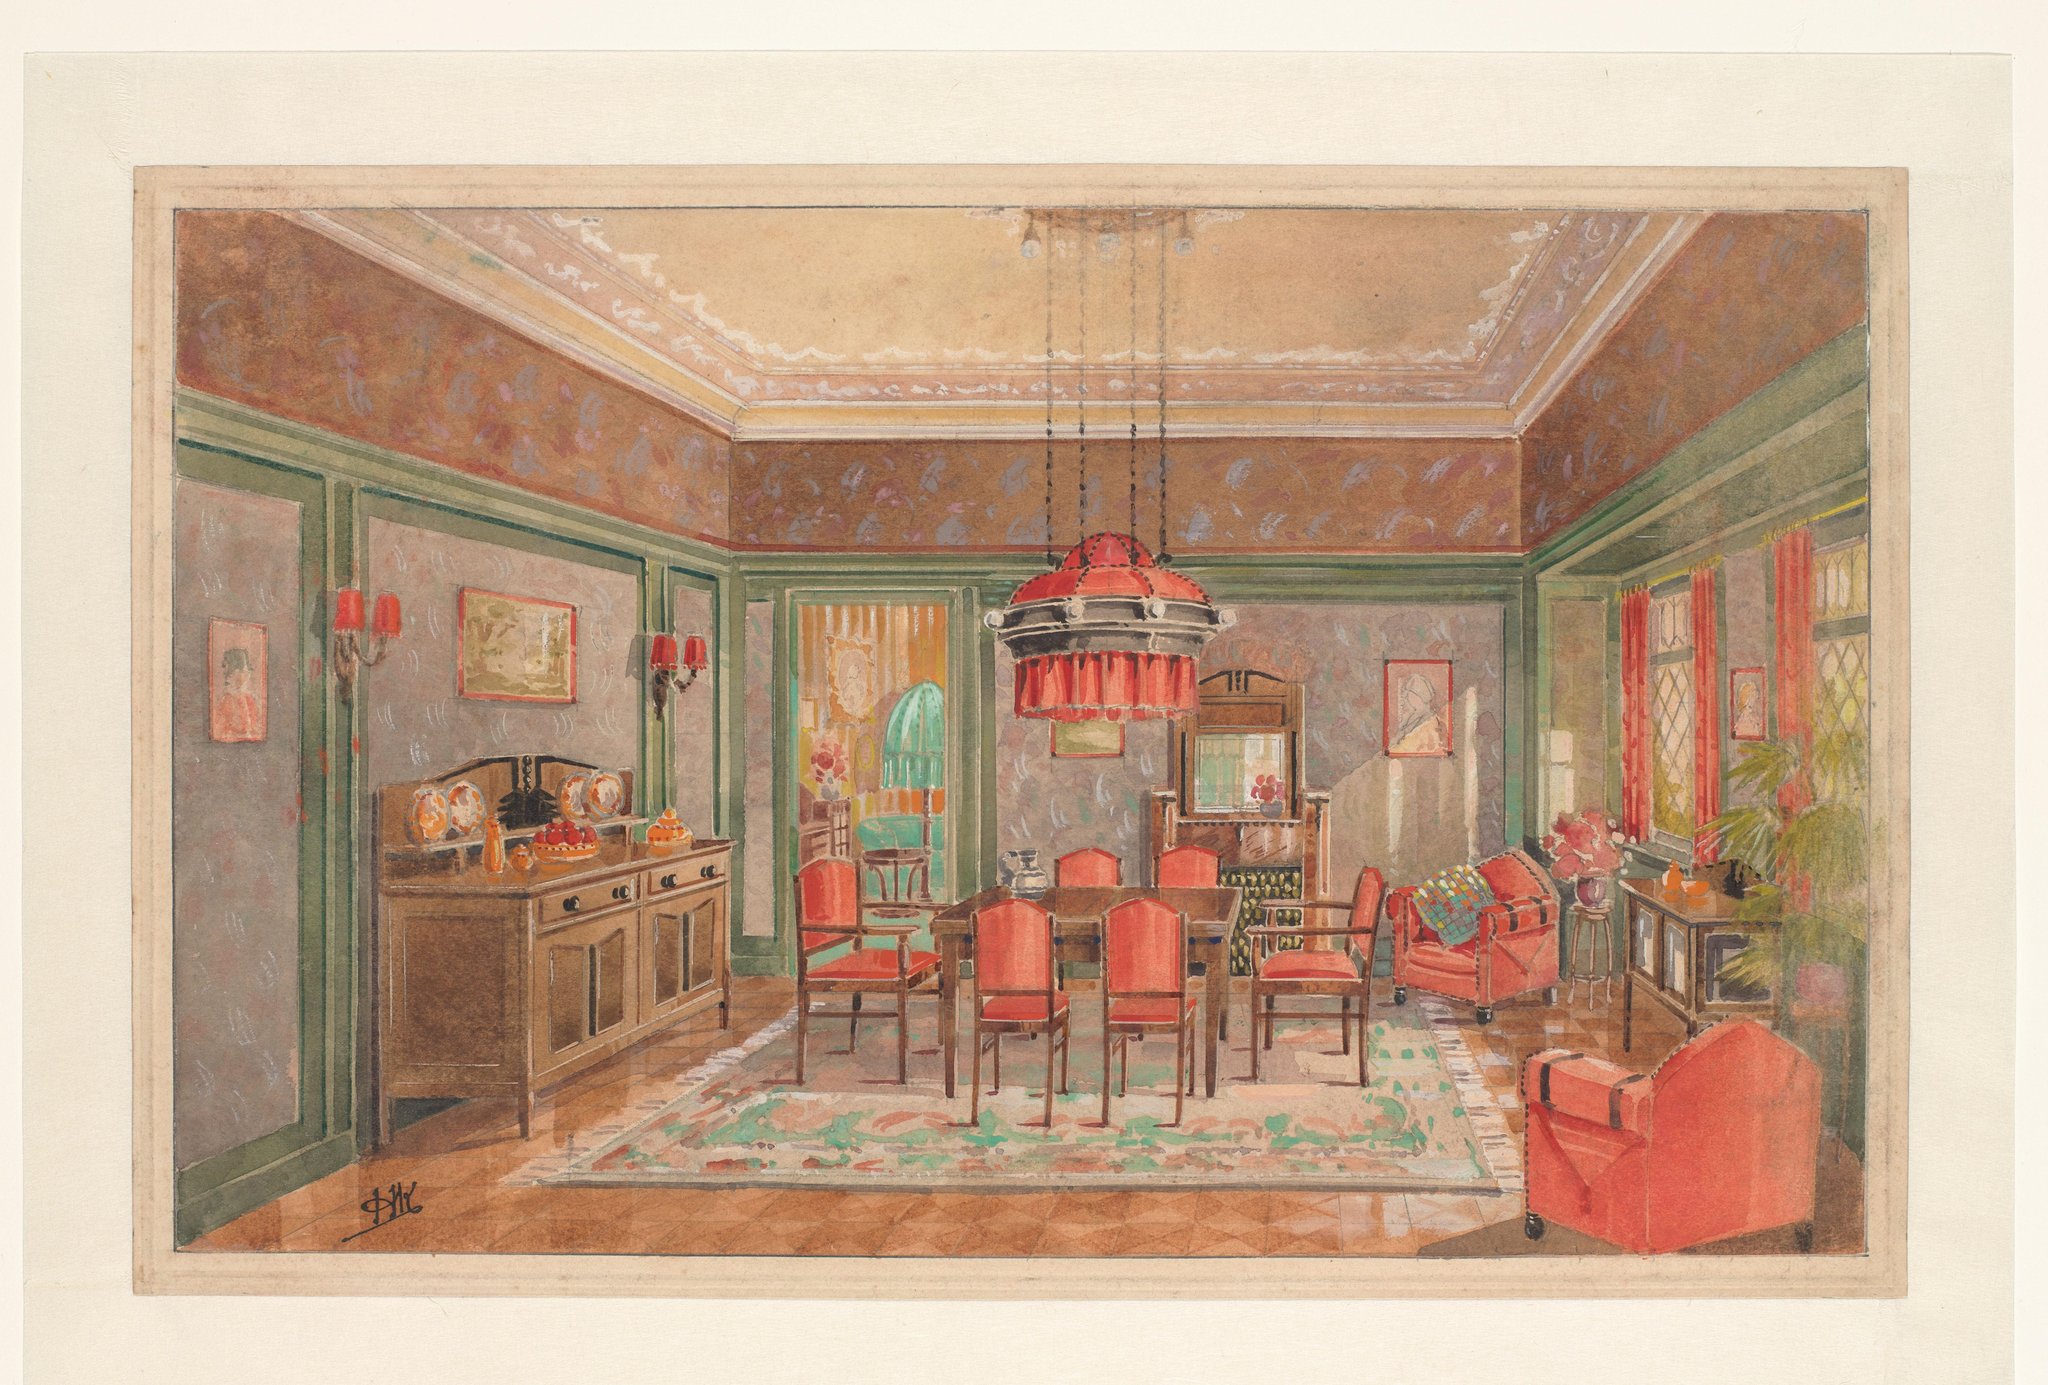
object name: watercolor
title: Eetkamer met rode stoelen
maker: monogrammist hk (nederland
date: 1925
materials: paper, watercolor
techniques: brush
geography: amsterdam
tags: dining-room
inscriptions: monogram: ‘HK’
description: Mogelijk is dit een demonstratietekeningen van een meubel- of inrichtingszaak.